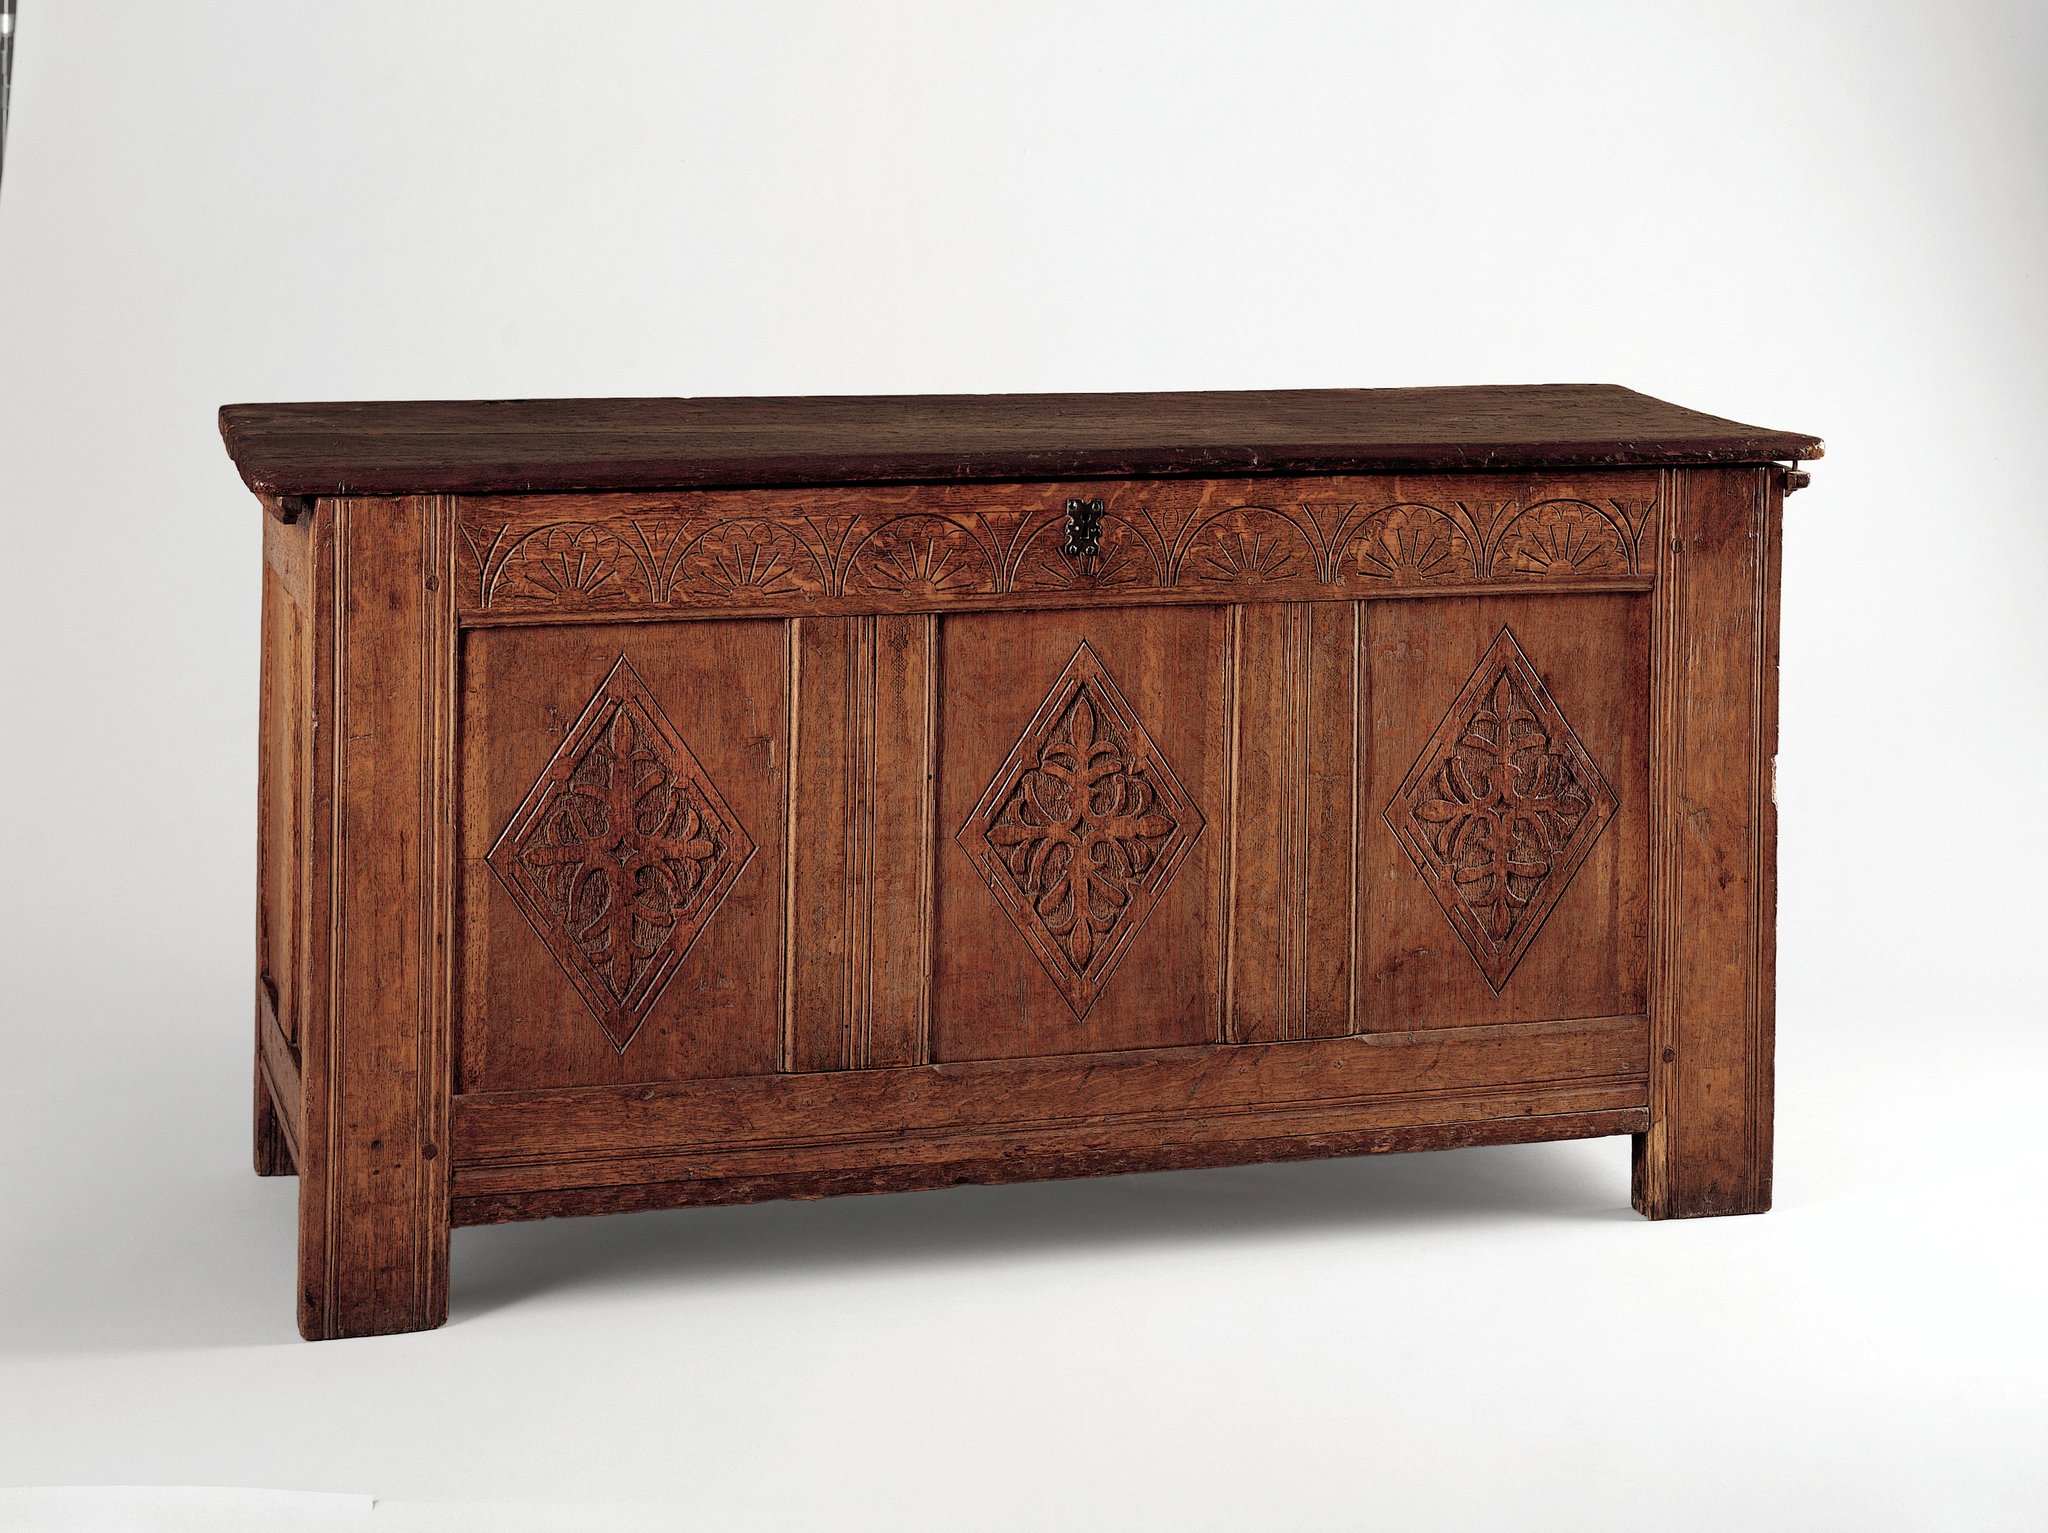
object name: chest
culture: american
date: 1650-1700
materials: wood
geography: united states